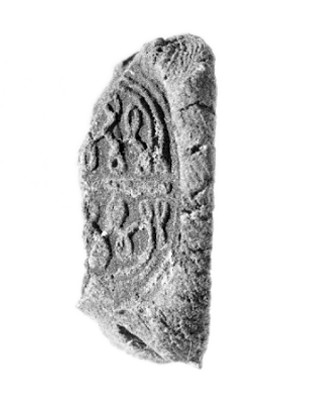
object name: sealing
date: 1981-1640 BCE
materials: mud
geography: egypt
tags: hieroglyphs